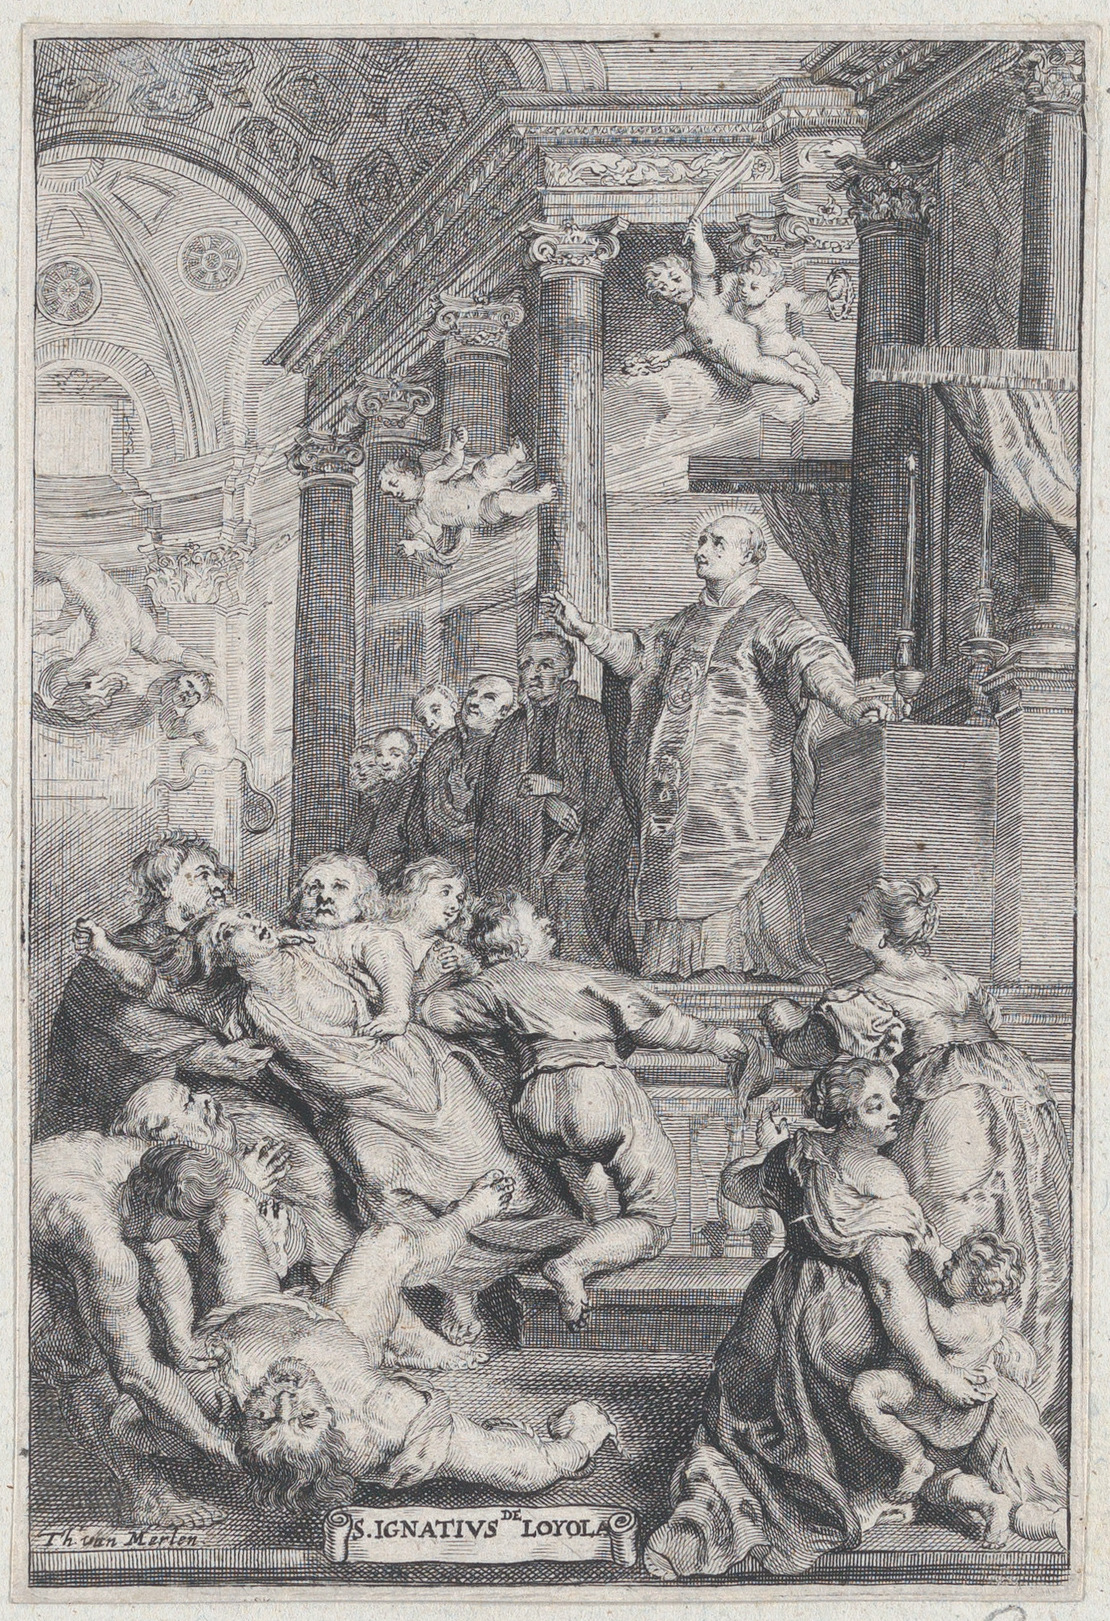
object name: print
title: The Miracles of Saint Ignatius of Loyola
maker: theodor van merlen ii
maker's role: artist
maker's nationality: flemish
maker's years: 1609-1672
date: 1633-1672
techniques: etching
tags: men,women,putti,saints